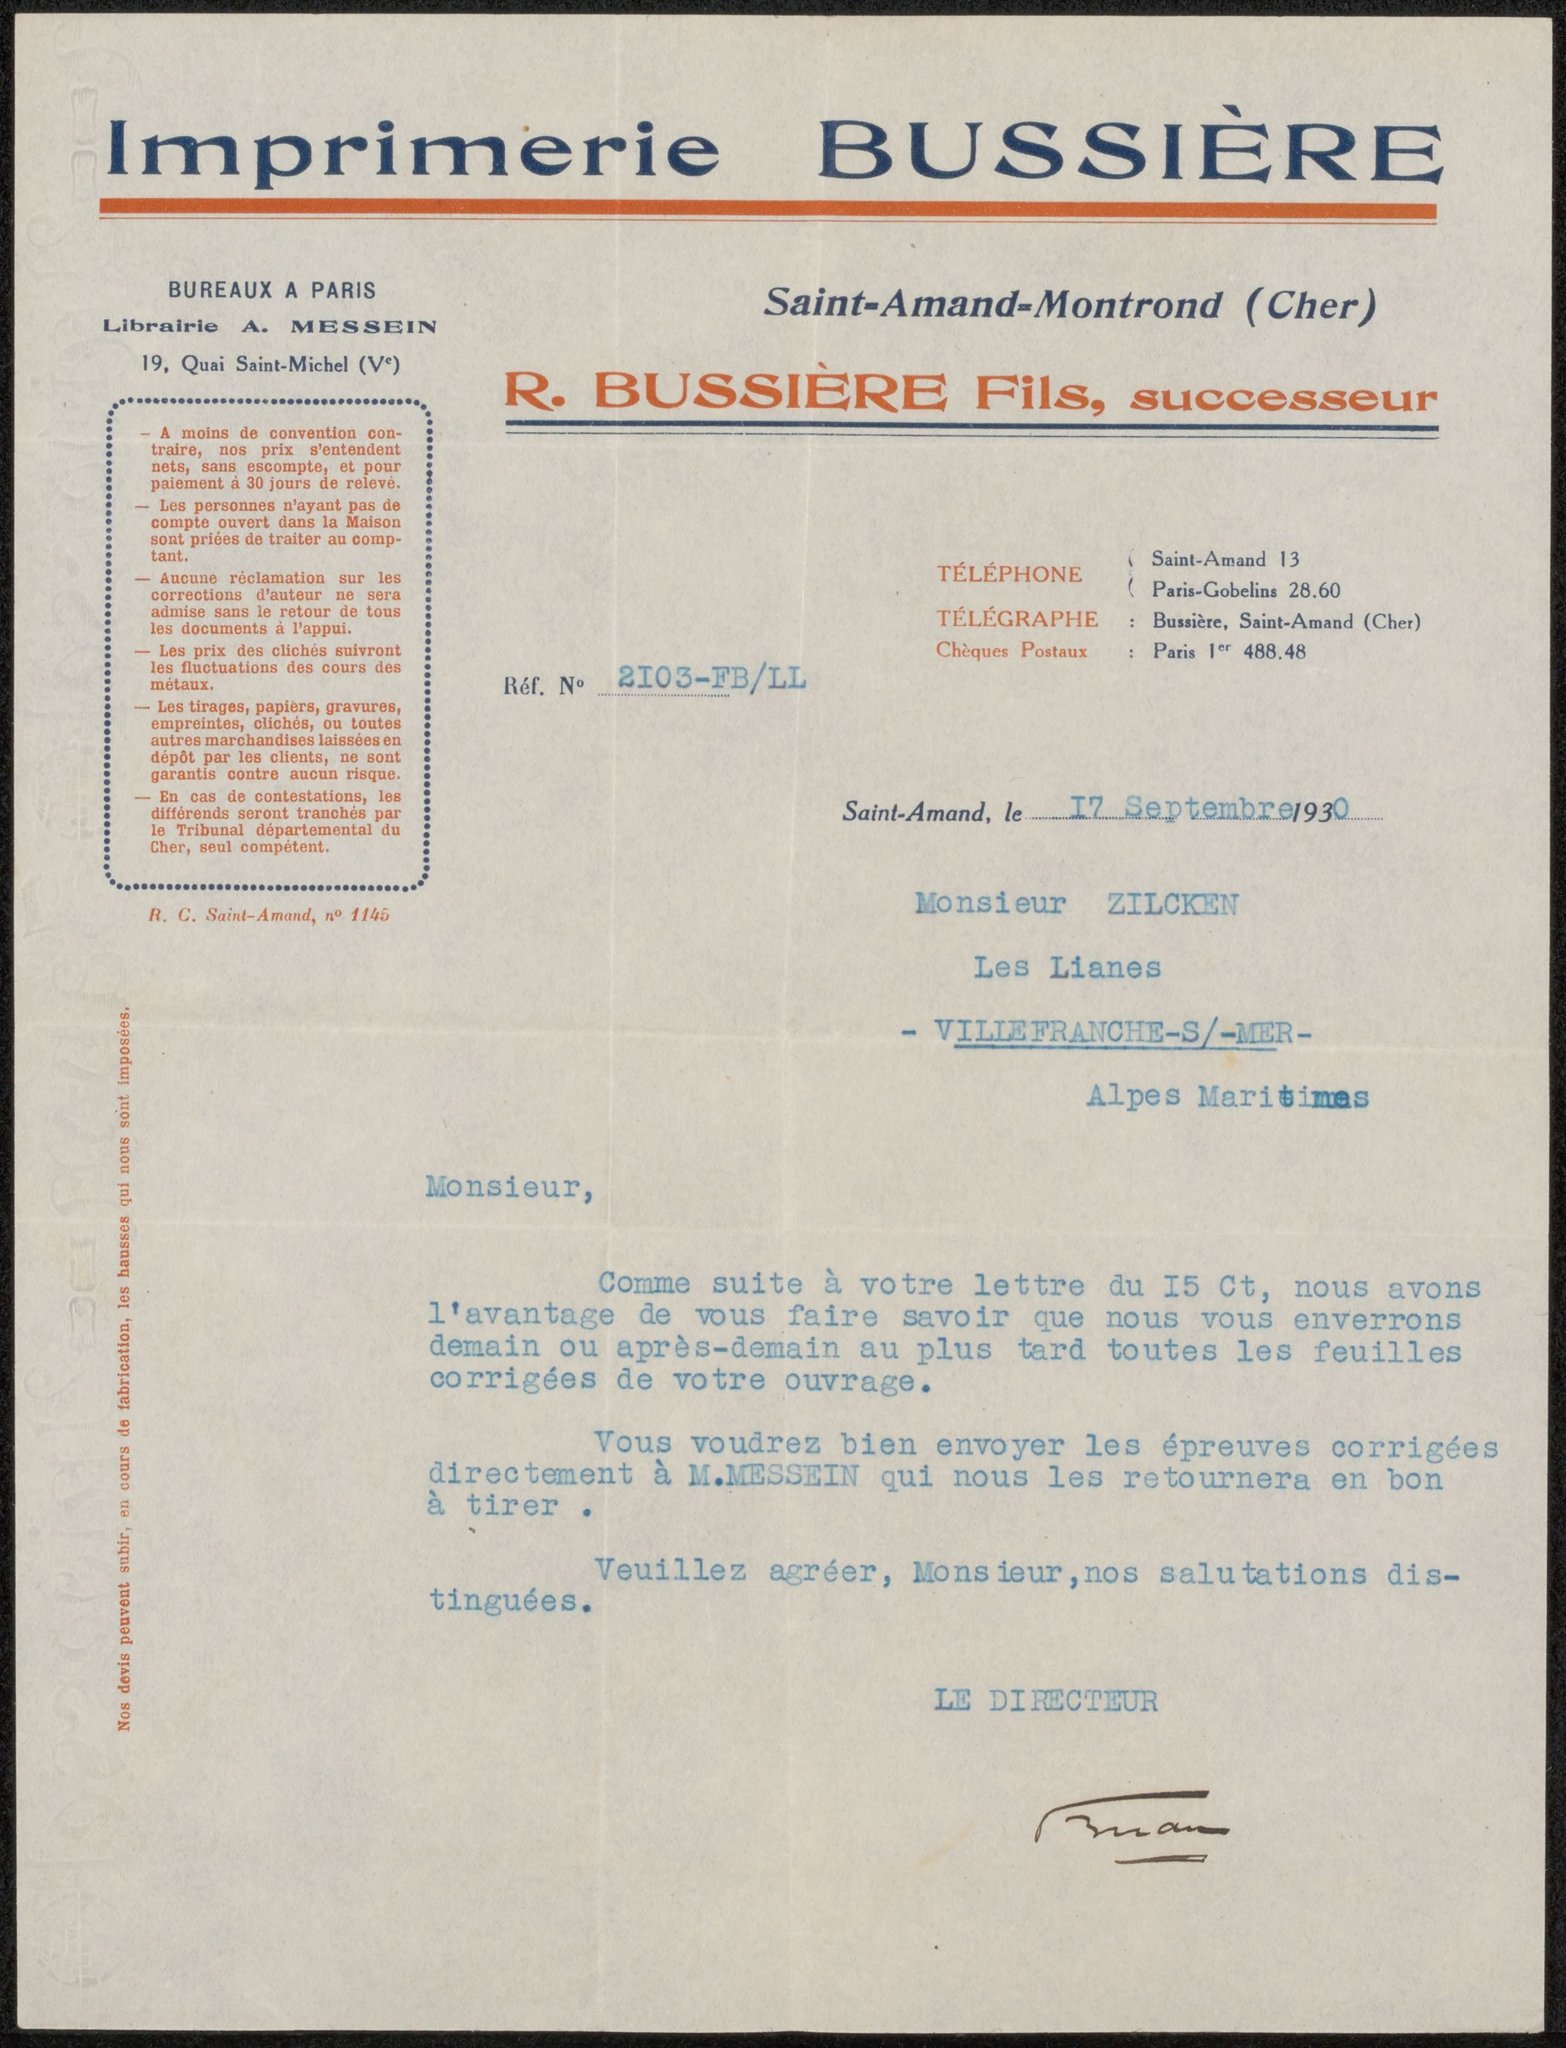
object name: envelope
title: Envelop aan Philip Zilcken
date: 1930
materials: ink, paper, pencil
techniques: pen, printing, writing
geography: saint-amand-montrond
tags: paris, albert messein, l. boudreaux, the hague, painter, draughtsman, philip zilcken